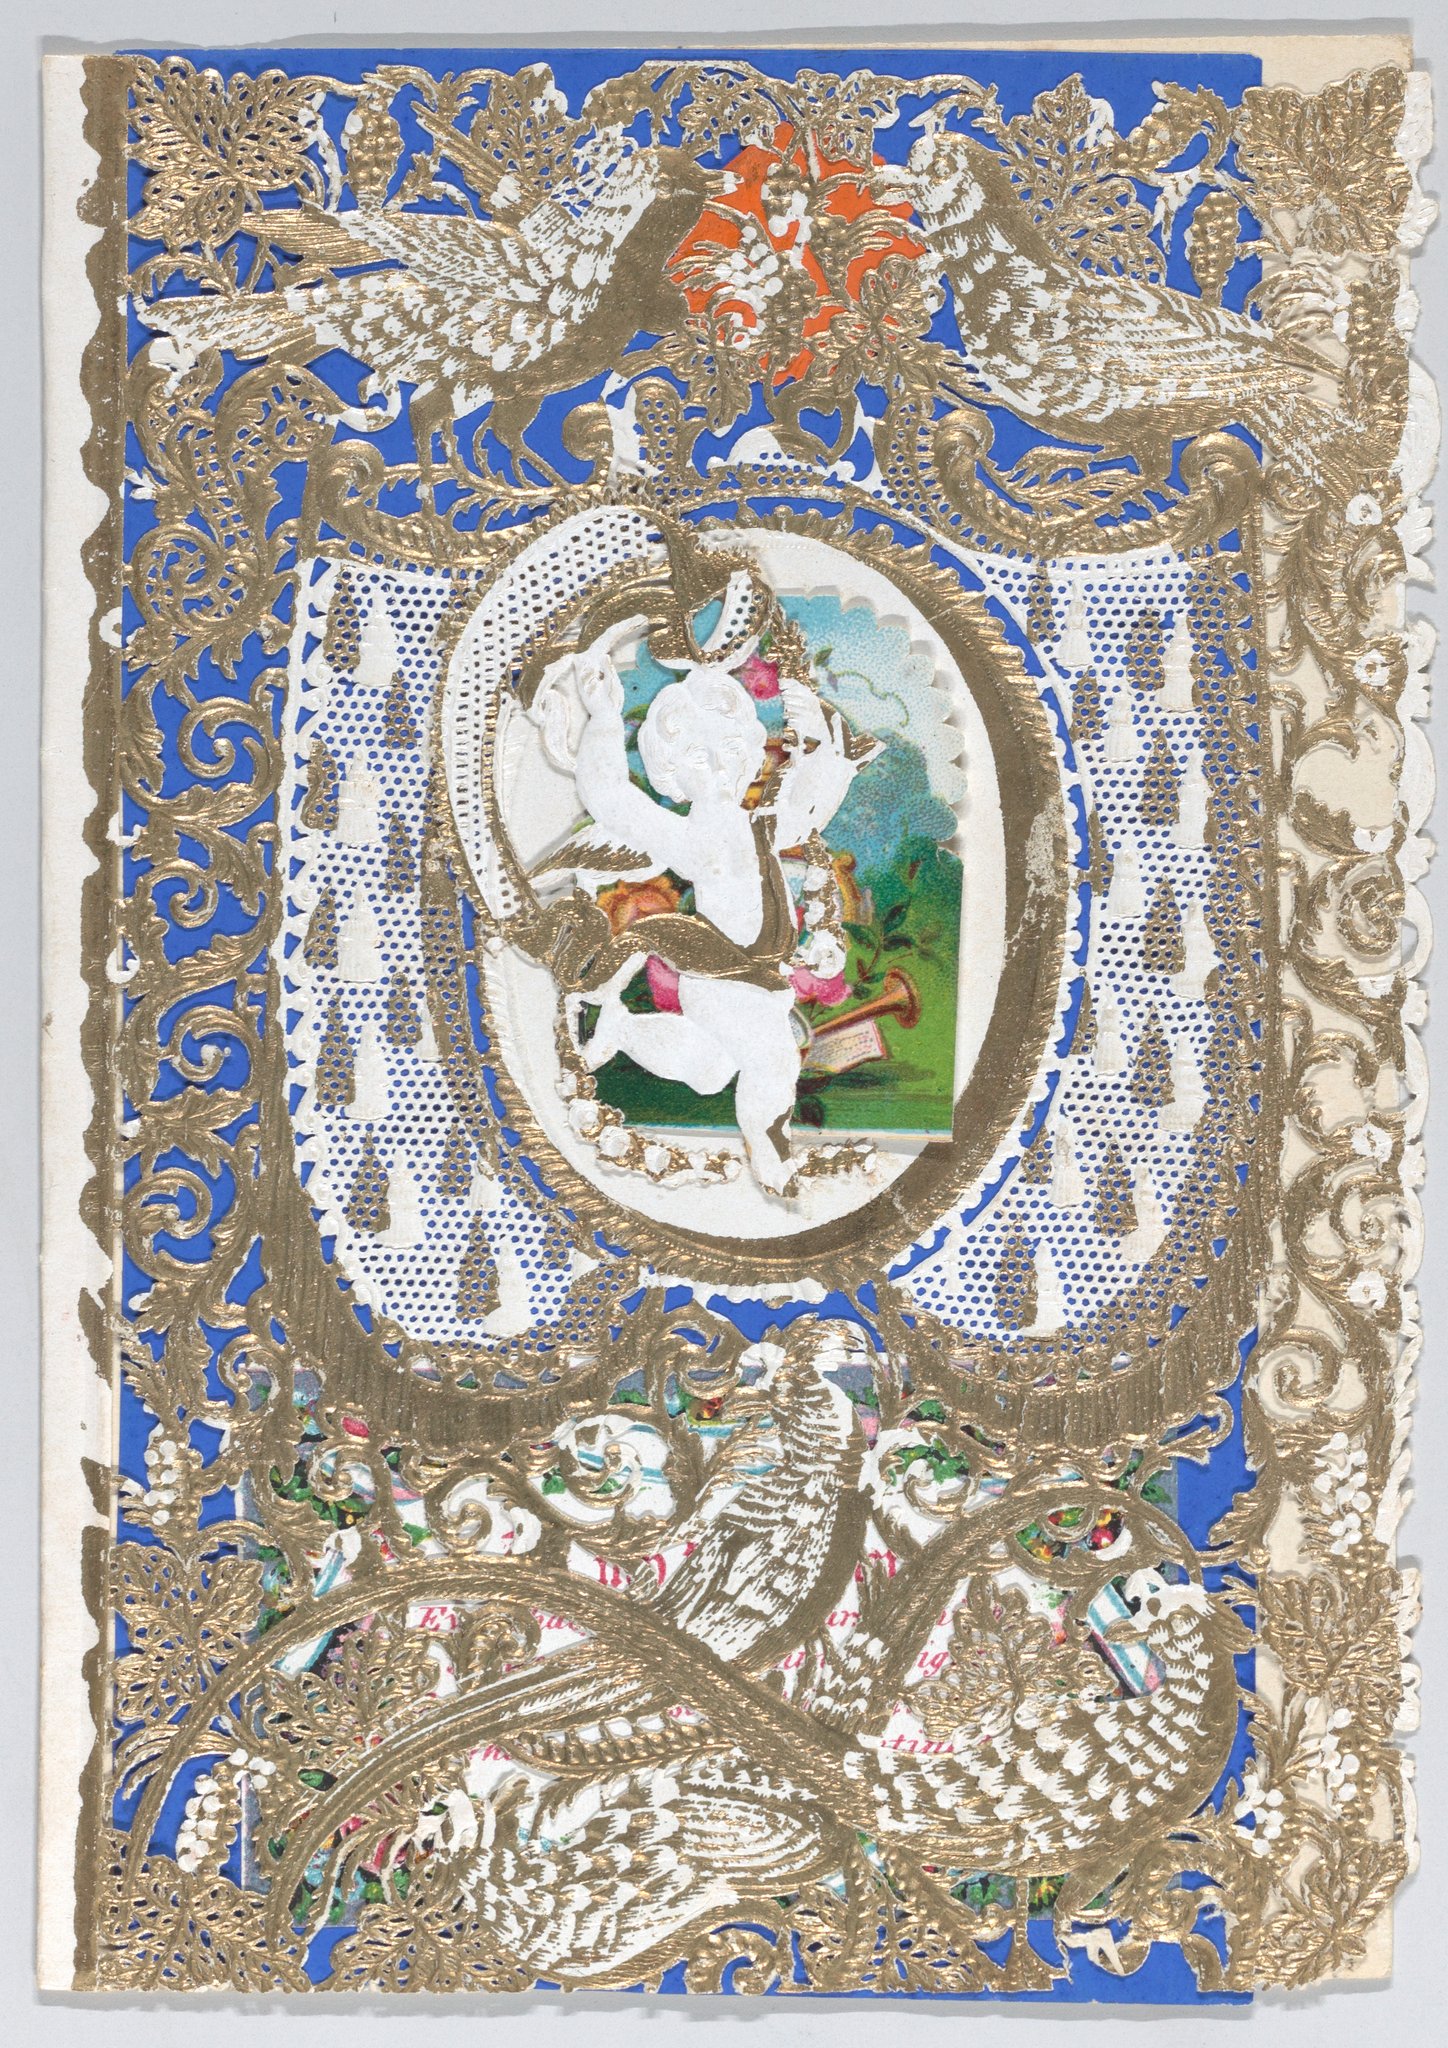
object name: valentine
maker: Anonymous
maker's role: artist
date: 1859-1869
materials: lace, paper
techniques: chromolithography, embossing, open work